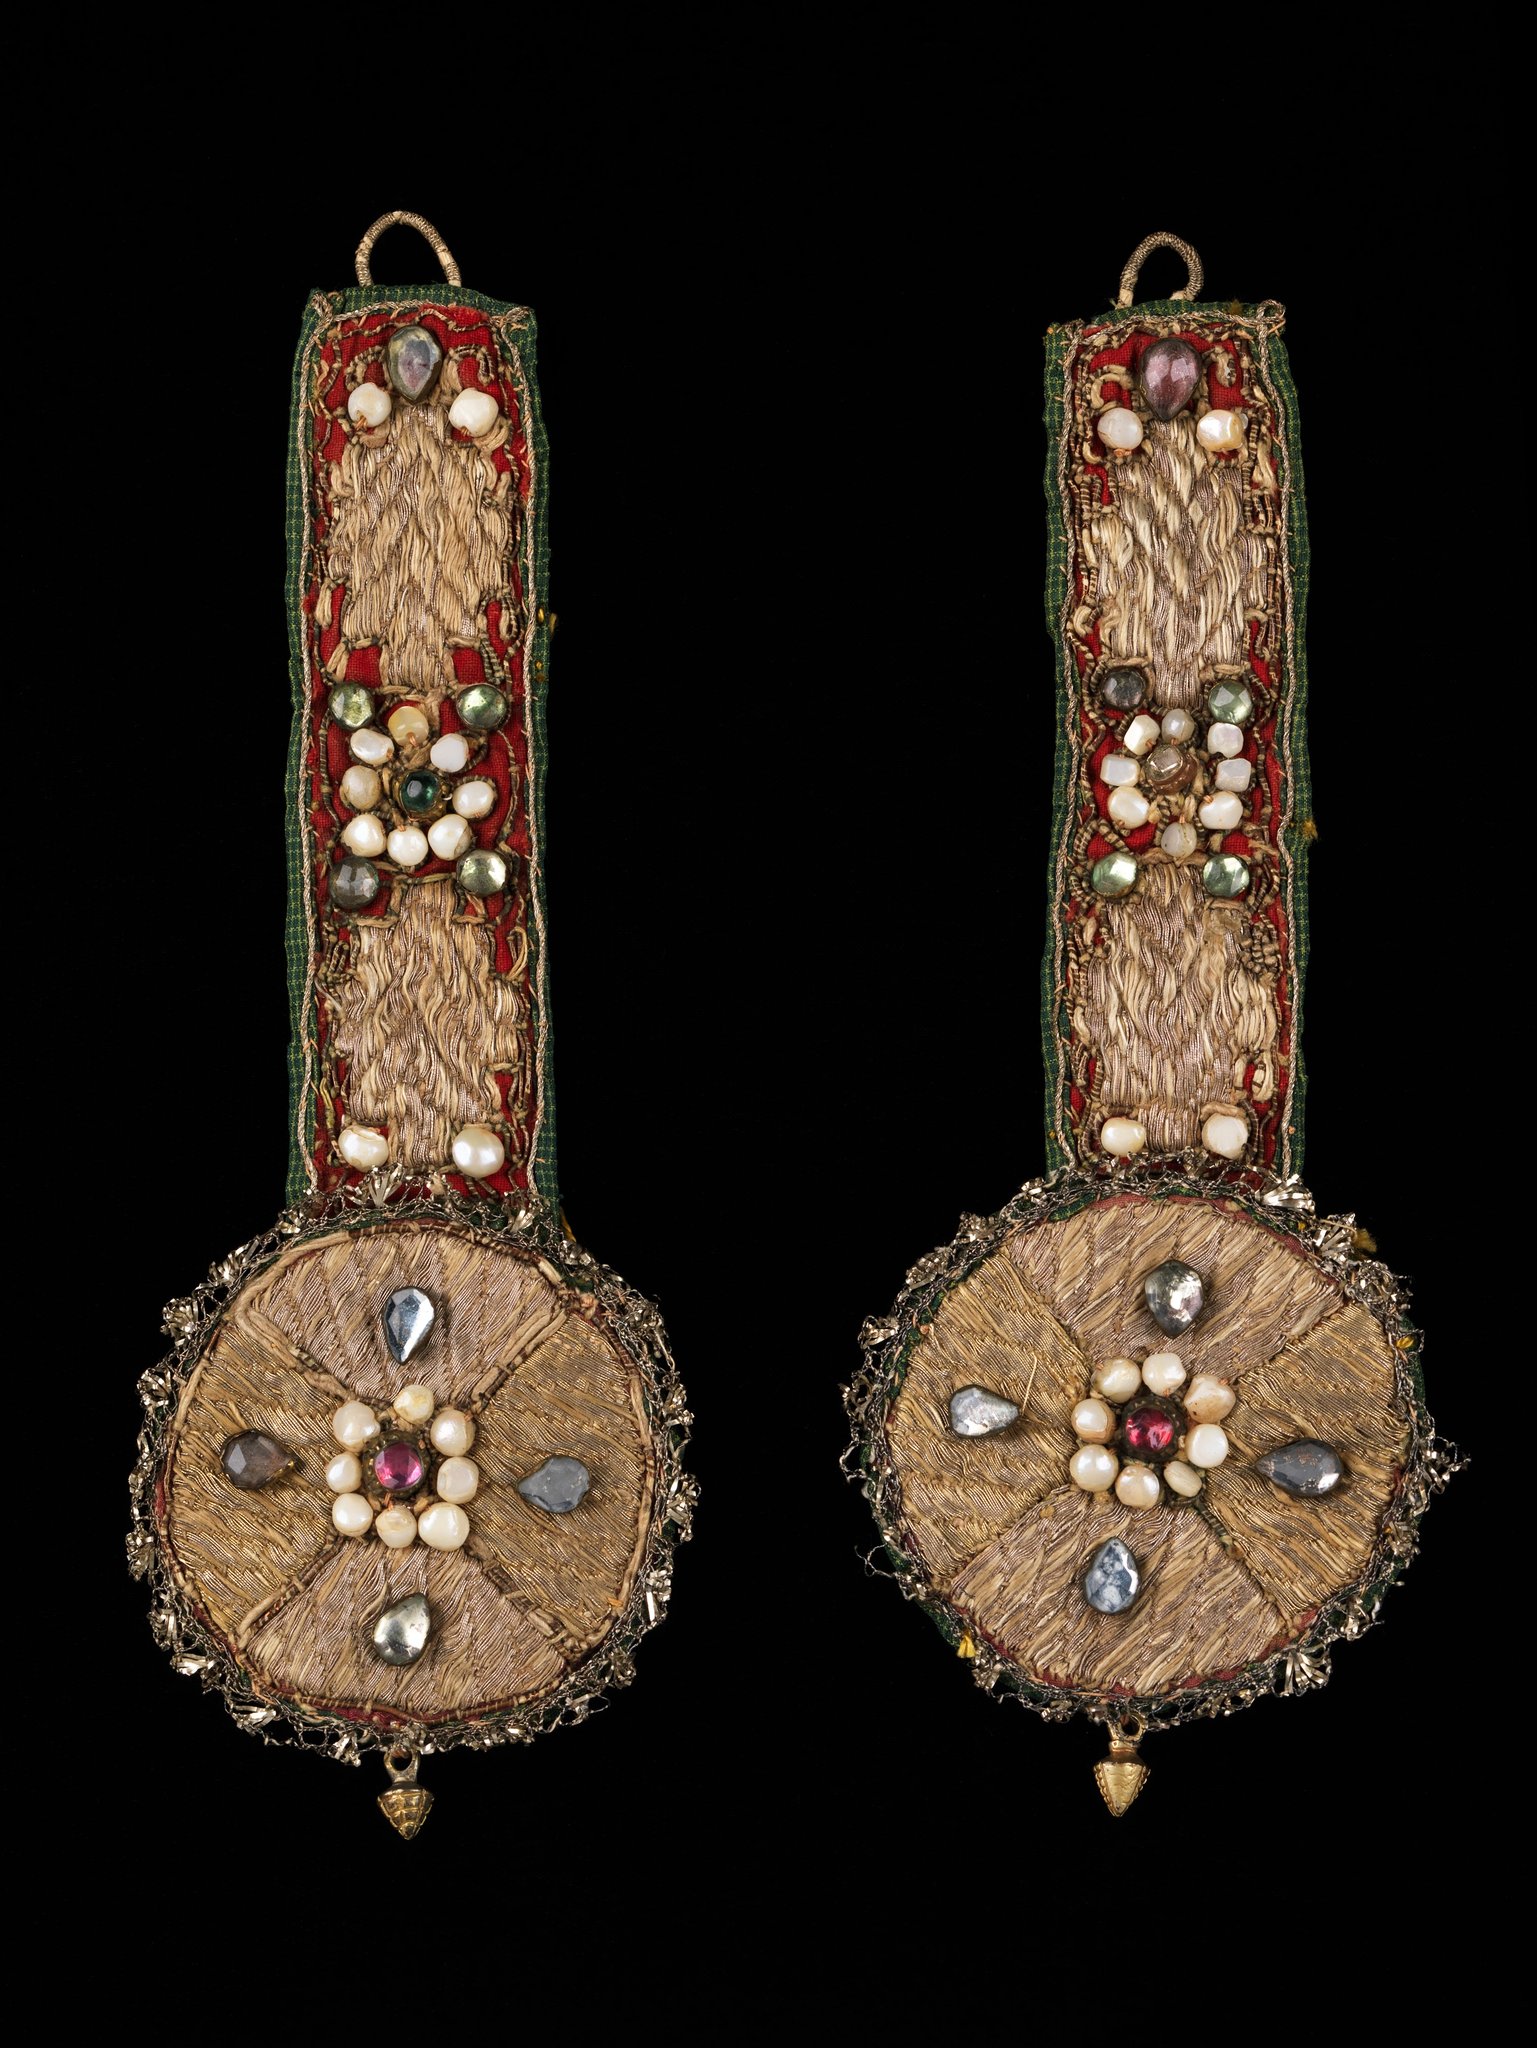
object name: ornament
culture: russian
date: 1801-1900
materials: cotton, glass, metal, mother of pearl, pearl, silk